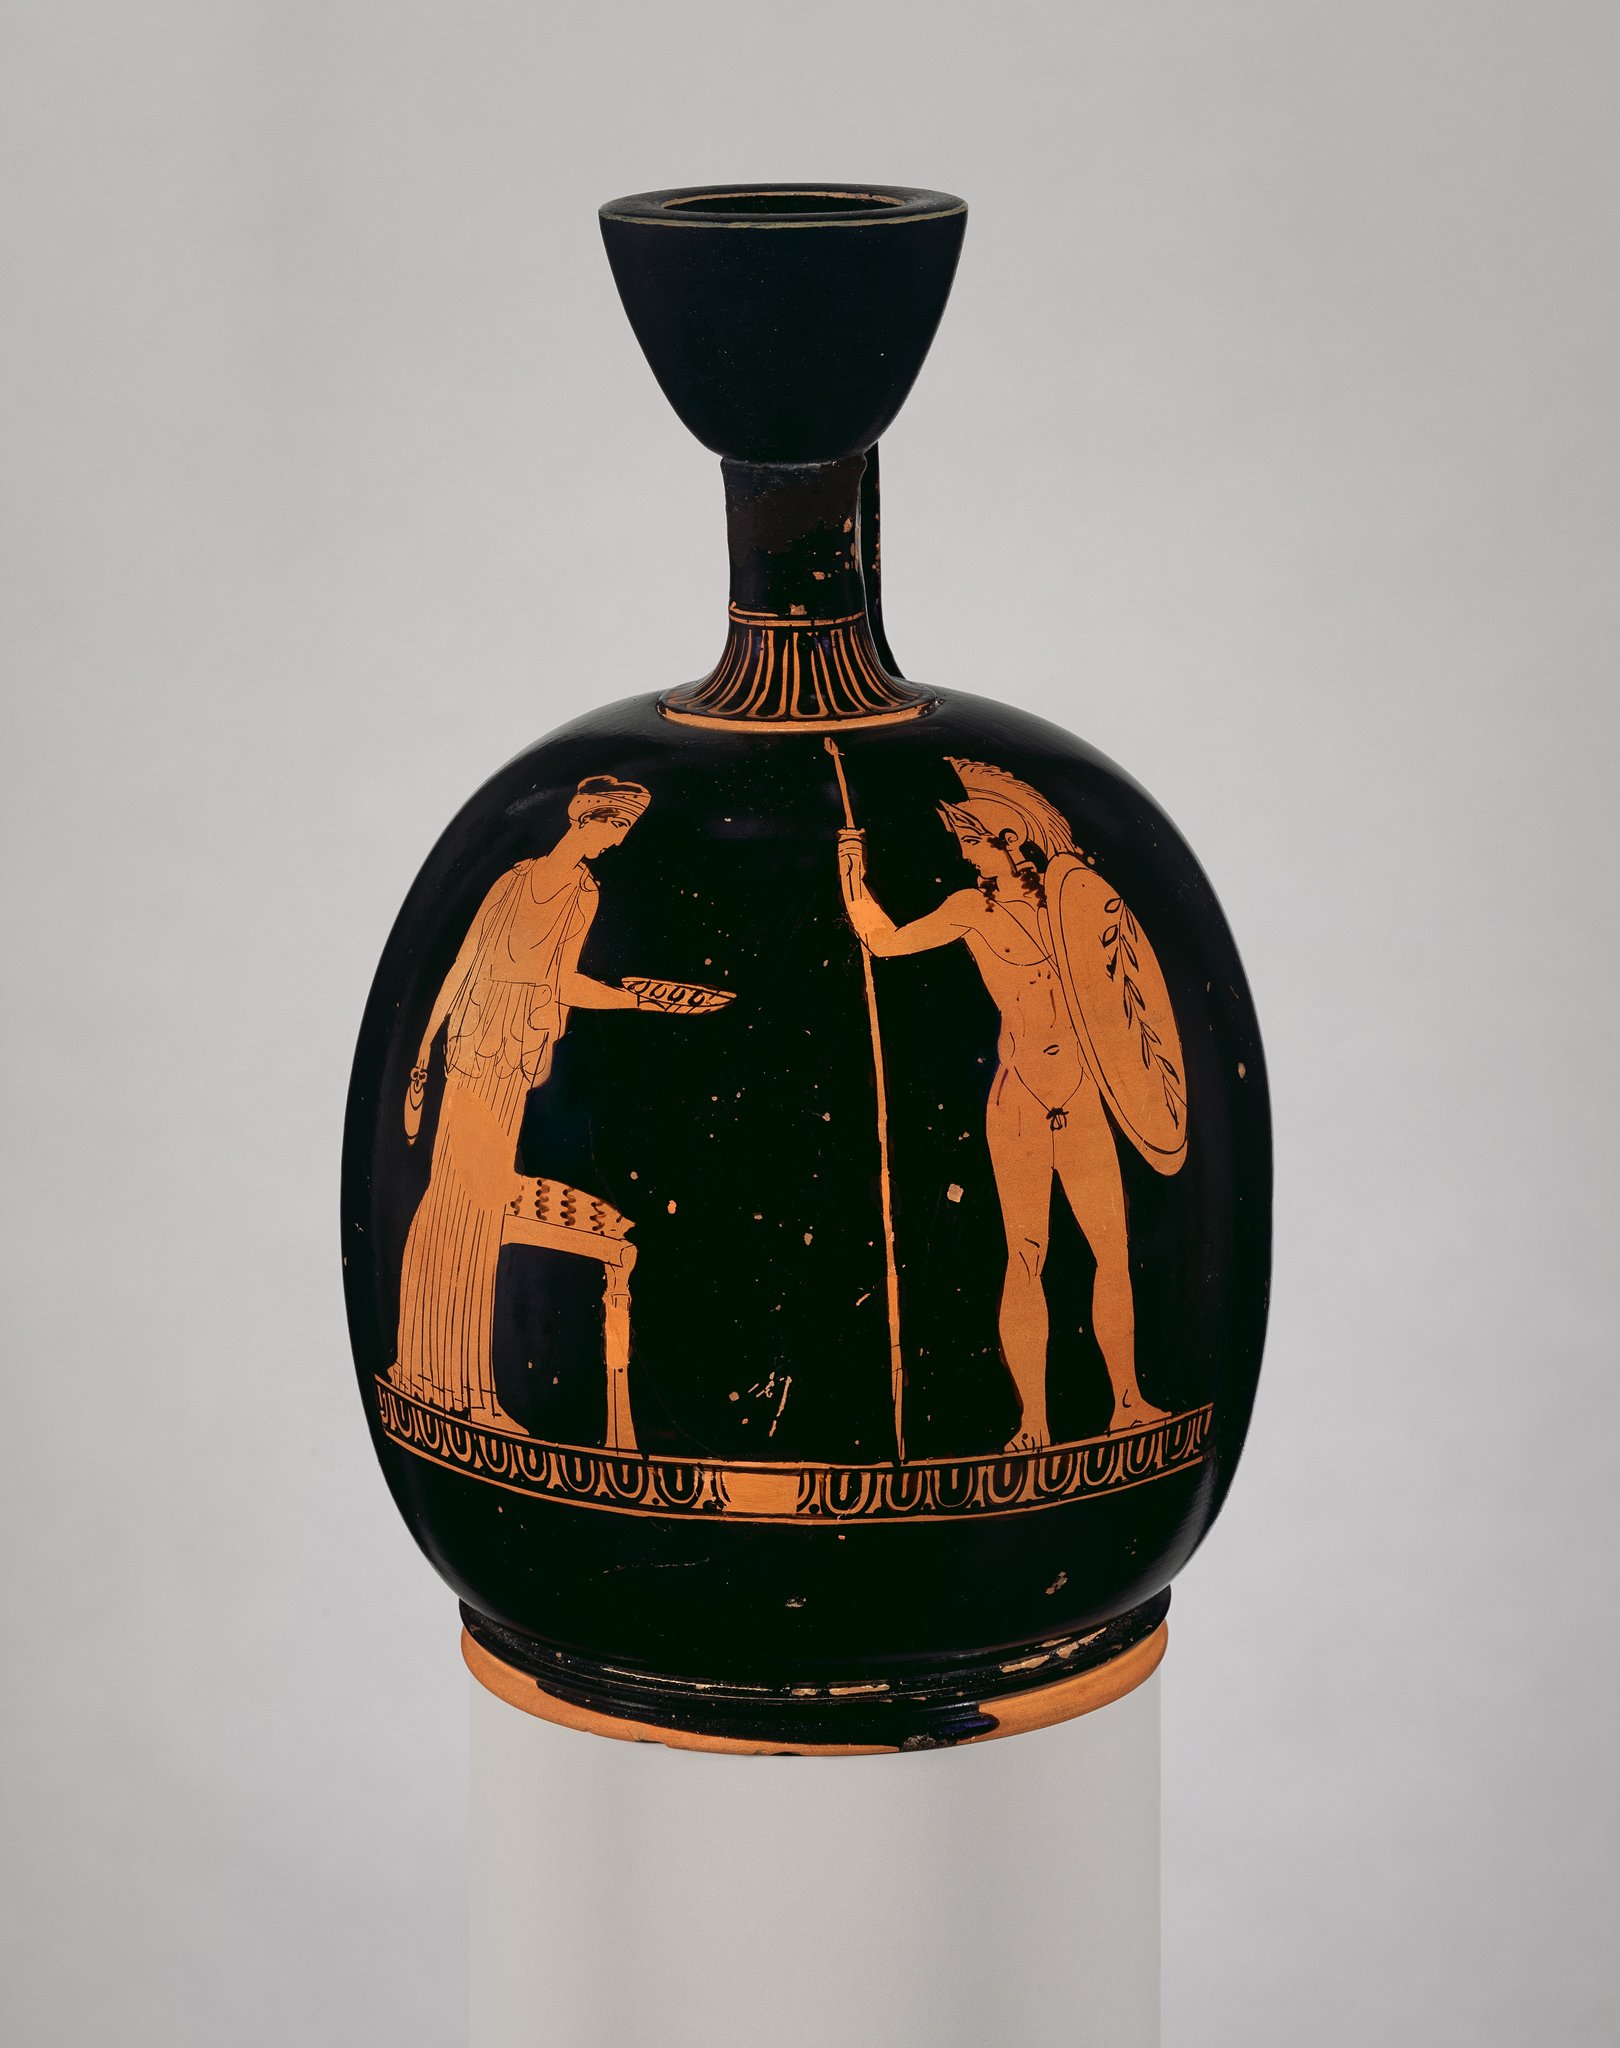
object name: lekythos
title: Terracotta squat lekythos (oil flask)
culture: greek, attic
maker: washing painter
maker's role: artist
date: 420 BCE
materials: terracotta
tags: male nudes,women,warriors